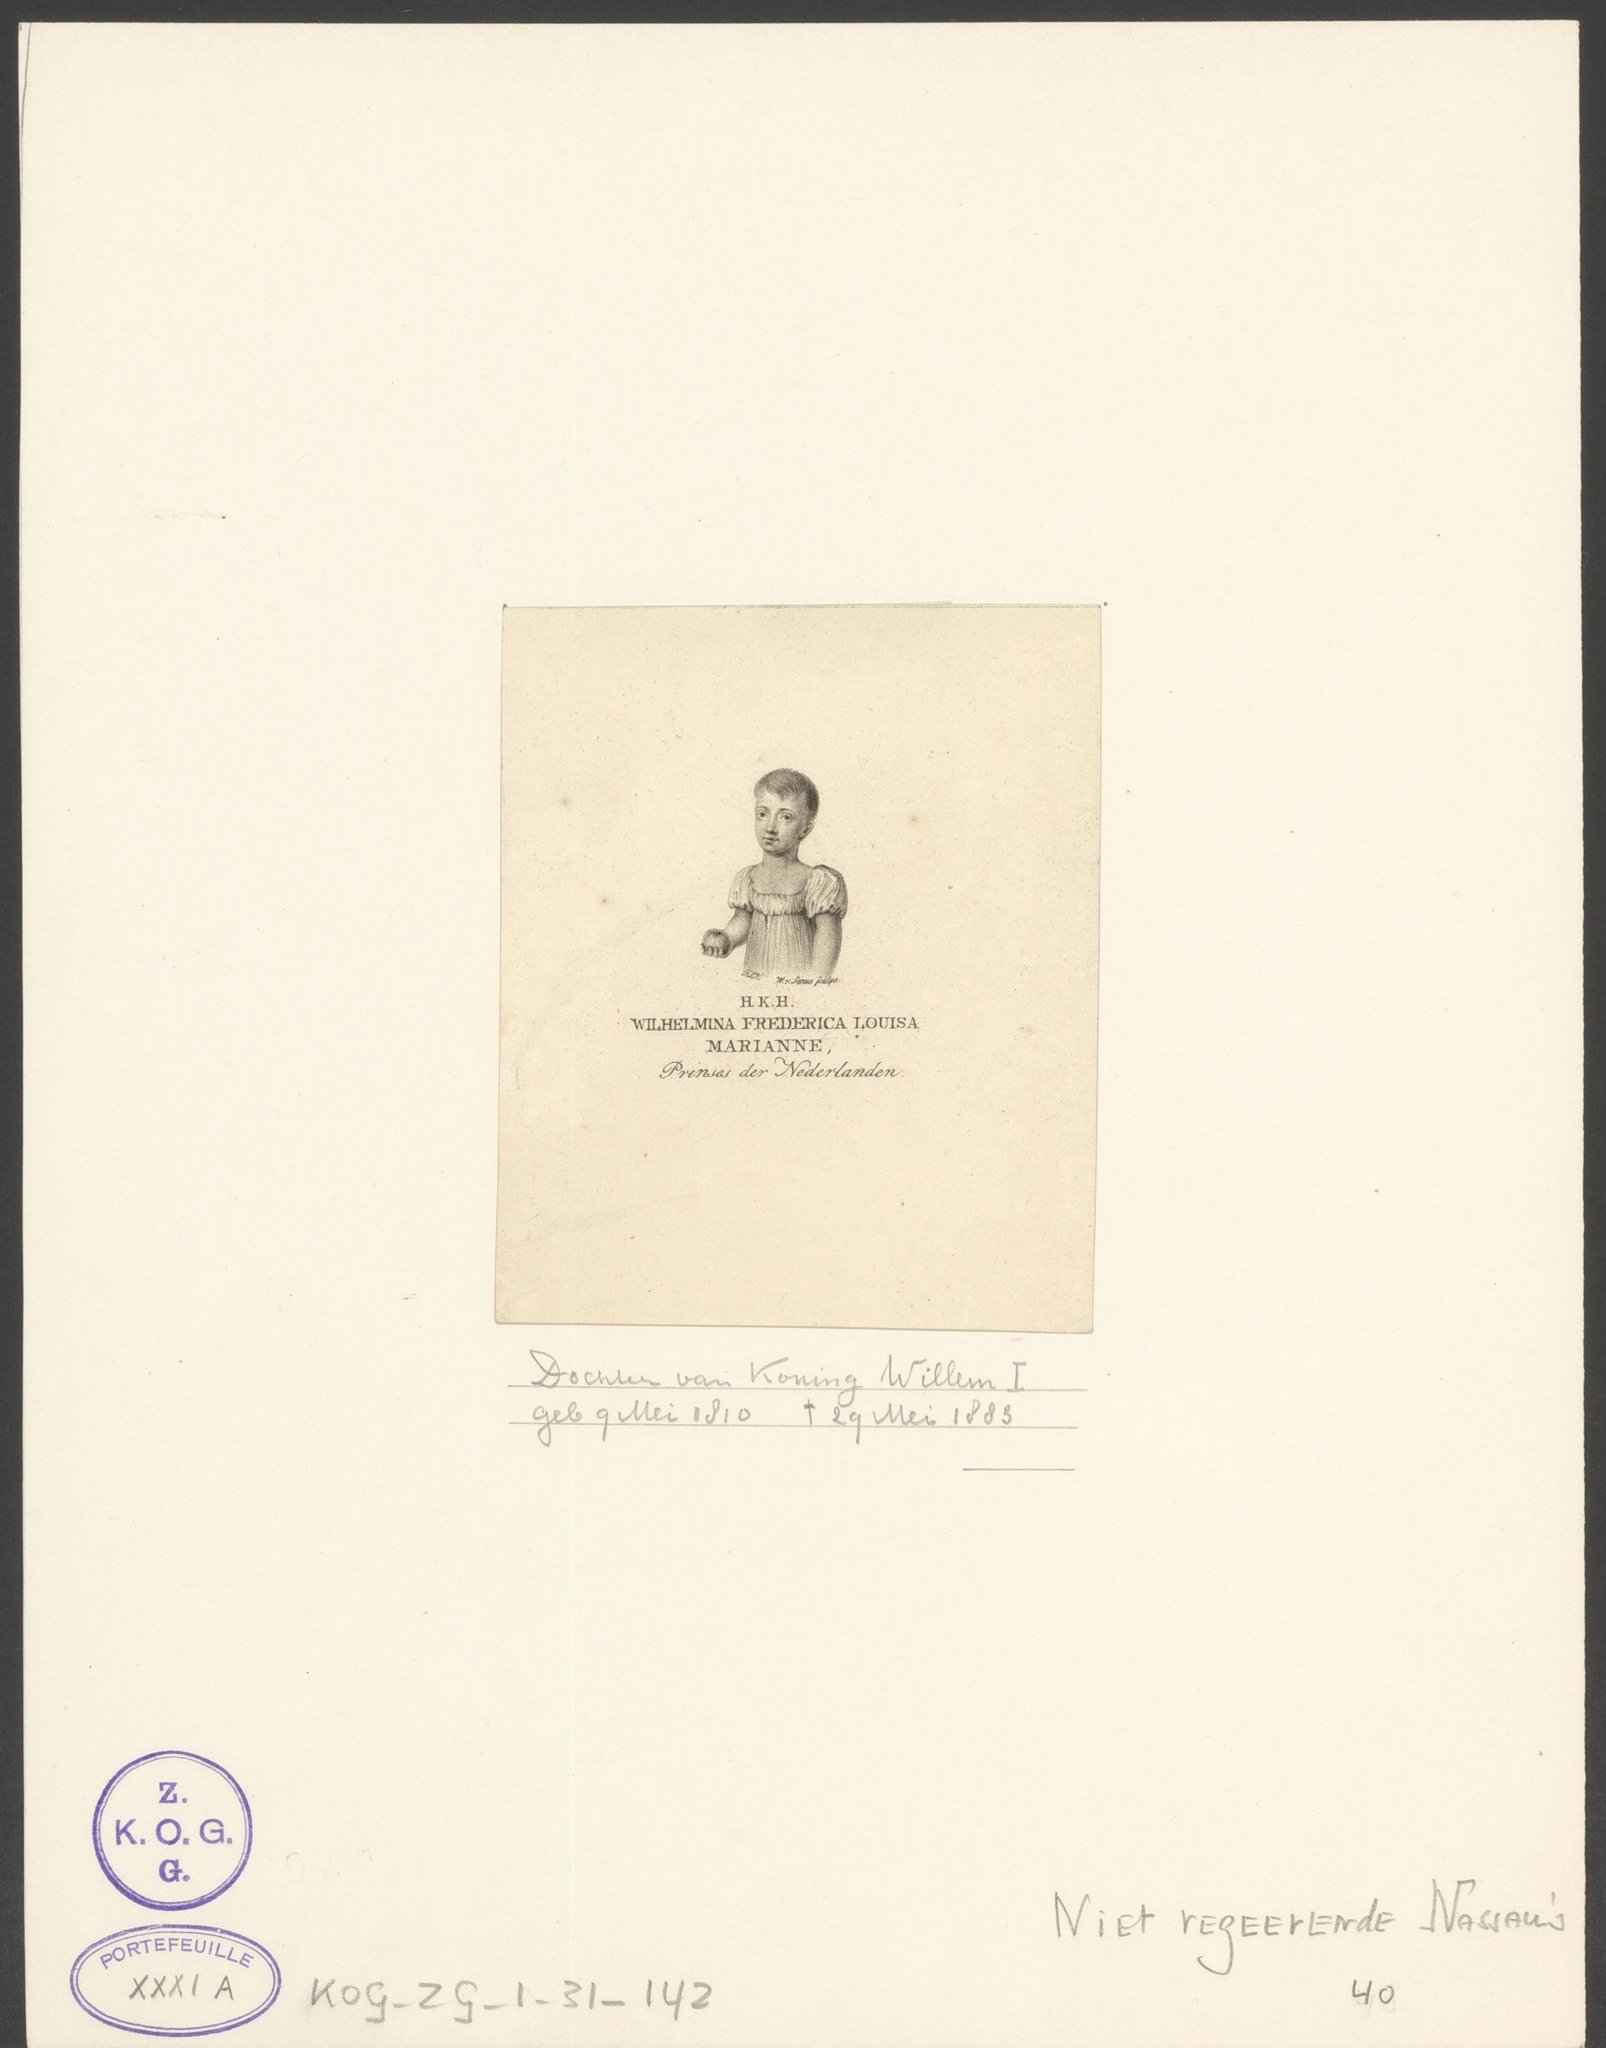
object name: print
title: Portret van Marianne, prinses der Nederlanden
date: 1810-1851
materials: paper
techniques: engraving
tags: berlin, voorburg, marianne (prinses der nederlanden), child, historical persons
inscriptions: stamp, collector's mark: Lugt 1641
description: Onderwerpsrubrieken binnen de Atlas Zeden en Gewoonten: Portretten, Portretten van Vorsten uit het huis van Oranje, Niet regeerende Vorsten.